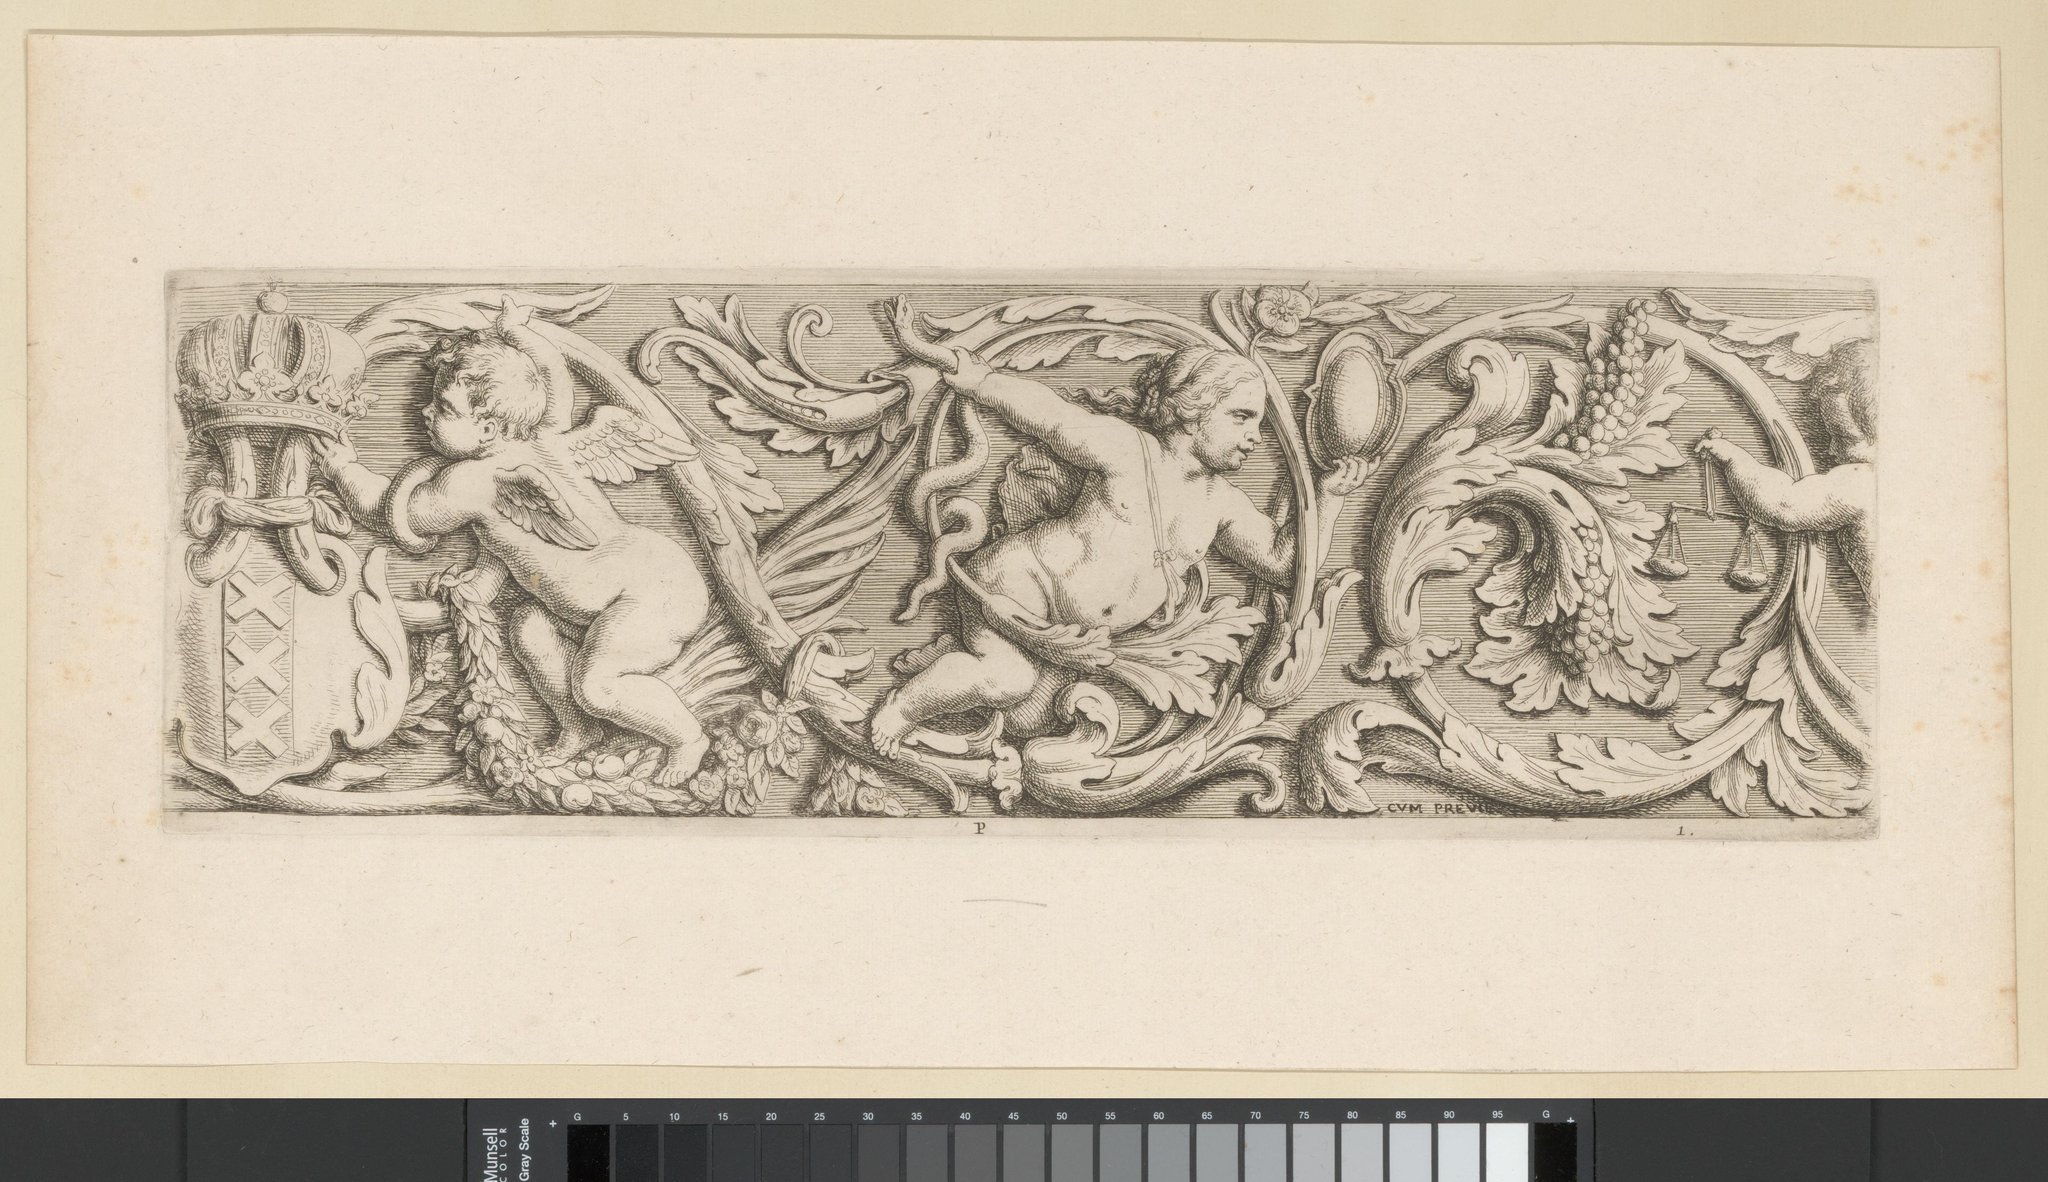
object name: print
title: Deel van fries op schouw in Burgemeesters Raadzaal van het Stadhuis op de Dam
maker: hubert quellinus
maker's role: print maker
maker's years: 1619-1687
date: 1663-1668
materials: paper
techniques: engraving, etching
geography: amsterdam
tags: coat of arms (as symbol of the state, etc.) (+ city; municipal), justice, 'justitia'; 'giustitia divina' (ripa) ~ one of the four cardinal virtues, prudence, 'prudentia'; 'prudenza' (ripa) ~ one of the four cardinal virtues, townhall, cupids: 'amores', 'amoretti', 'putti'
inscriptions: collector's mark: ‘16,83’ Lugt 1641b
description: Prent gebruikt in: Secunca pars Praecipuarum effigierum ac ornamentorum amplissime Curiae Amstelrodamensis maiori ex parte in cadido marmore effectorum per Artum Quellinium eiusdem Civitatis Statuarium / Het tweede deel Van de voornaemste Statuen ende Cieraten van 't konst-rijcke Stadt-huys van Amstelredam 'tmeeste in Marmer gemaeckt door Artus Quellinus Beelthouwer der voorseyde Stadt. Amsterdam: Artus Quellinus (I), 1663. Zie RP-P-AO-22-2-1 voor bijhorende titelpagina. Zie RP-P-AO-22-2-2 voor bijhorend register. Zie RP-P-AO-22-2A, RP-P-AO-22-2B, RP-P-AO-22-2C-1, RP-P-AO-22-2C-2, RP-P-AO-22-2C-3, RP-P-AO-22-2C-4, RP-P-AO-22-2D-1, RP-P-AO-22-2D-2, RP-P-AO-22-2D-3, RP-P-AO-22-2E-1, RP-P-AO-22-2E-2, RP-P-AO-22-2E-3, RP-P-AO-22-2E-4, RP-P-AO-22-2F-1, RP-P-AO-22-2F-2, RP-P-AO-22-2F-3, RP-P-AO-22-2G, RP-P-AO-22-2H, RP-P-AO-22-2I, RP-P-AO-22-2K, RP-P-AO-22-2L, RP-P-AO-22-2M, RP-P-AO-22-2N, RP-P-AO-22-2O-1, RP-P-AO-22-2O-2, RP-P-AO-22-2O-3, RP-P-AO-22-2O-4, RP-P-AO-22-2O-5, RP-P-AO-22-2O-6, RP-P-AO-22-2O-7, RP-P-AO-22-2P-2, RP-P-AO-22-2Q-1, RP-P-AO-22-2Q-2, RP-P-AO-22-2Q-3, RP-P-AO-22-2R-1, RP-P-AO-22-2R-2, RP-P-AO-22-2R-3, RP-P-AO-22-2S, RP-P-AO-22-2T-1, RP-P-AO-22-2T-2, RP-P-AO-22-2T-3, RP-P-AO-22-2T-4, RP-P-AO-22-2V-1, RP-P-AO-22-2V-2, RP-P-AO-22-2W-1, RP-P-AO-22-2W-2, RP-P-AO-22-2X-1, RP-P-AO-22-2X-2 en RP-P-AO-22-2X-3 voor andere prenten uit deze publicatie. Zelfde staat van prent ook gebruikt in: Secunca pars Praecipuarum effigierum ac ornamentorum amplissime Curiae Amstelrodamensis maiori ex parte in cadido marmore effectorum per Artum Quellinium eiusdem Civitatis Statuarium / Het tweede deel Van de voornaemste Statuen ende Cieraten van 't konst-rijcke Stadt-huys van Amstelredam 'tmeeste in Marmer gemaeckt door Artus Quellinus Beelthouwer der voorseyde Stadt. Amsterdam: Frederik de Wit, 1668. Latere staat van prent ook gebruikt in: Architecture peinture et sculpture de la Maison de Ville d'Amsterdam, representee en CIX. figures en taille-douce (…). Amsterdam: David Mortier, 1719. En in: Architecture peinture et sculpture de la Maison de Ville d'Amsterdam, representee en CIX. figures en taille-douce (…). Amsterdam: Gerard Valck, 1719. En in: Bouw schilder en beeldhouwkonst, van het Stadhuis te Amsteldam, vertoont in CIX figuuren (…). Amsterdam: Covens & Mortier & Covens Jr., s.a. (1774-1783).